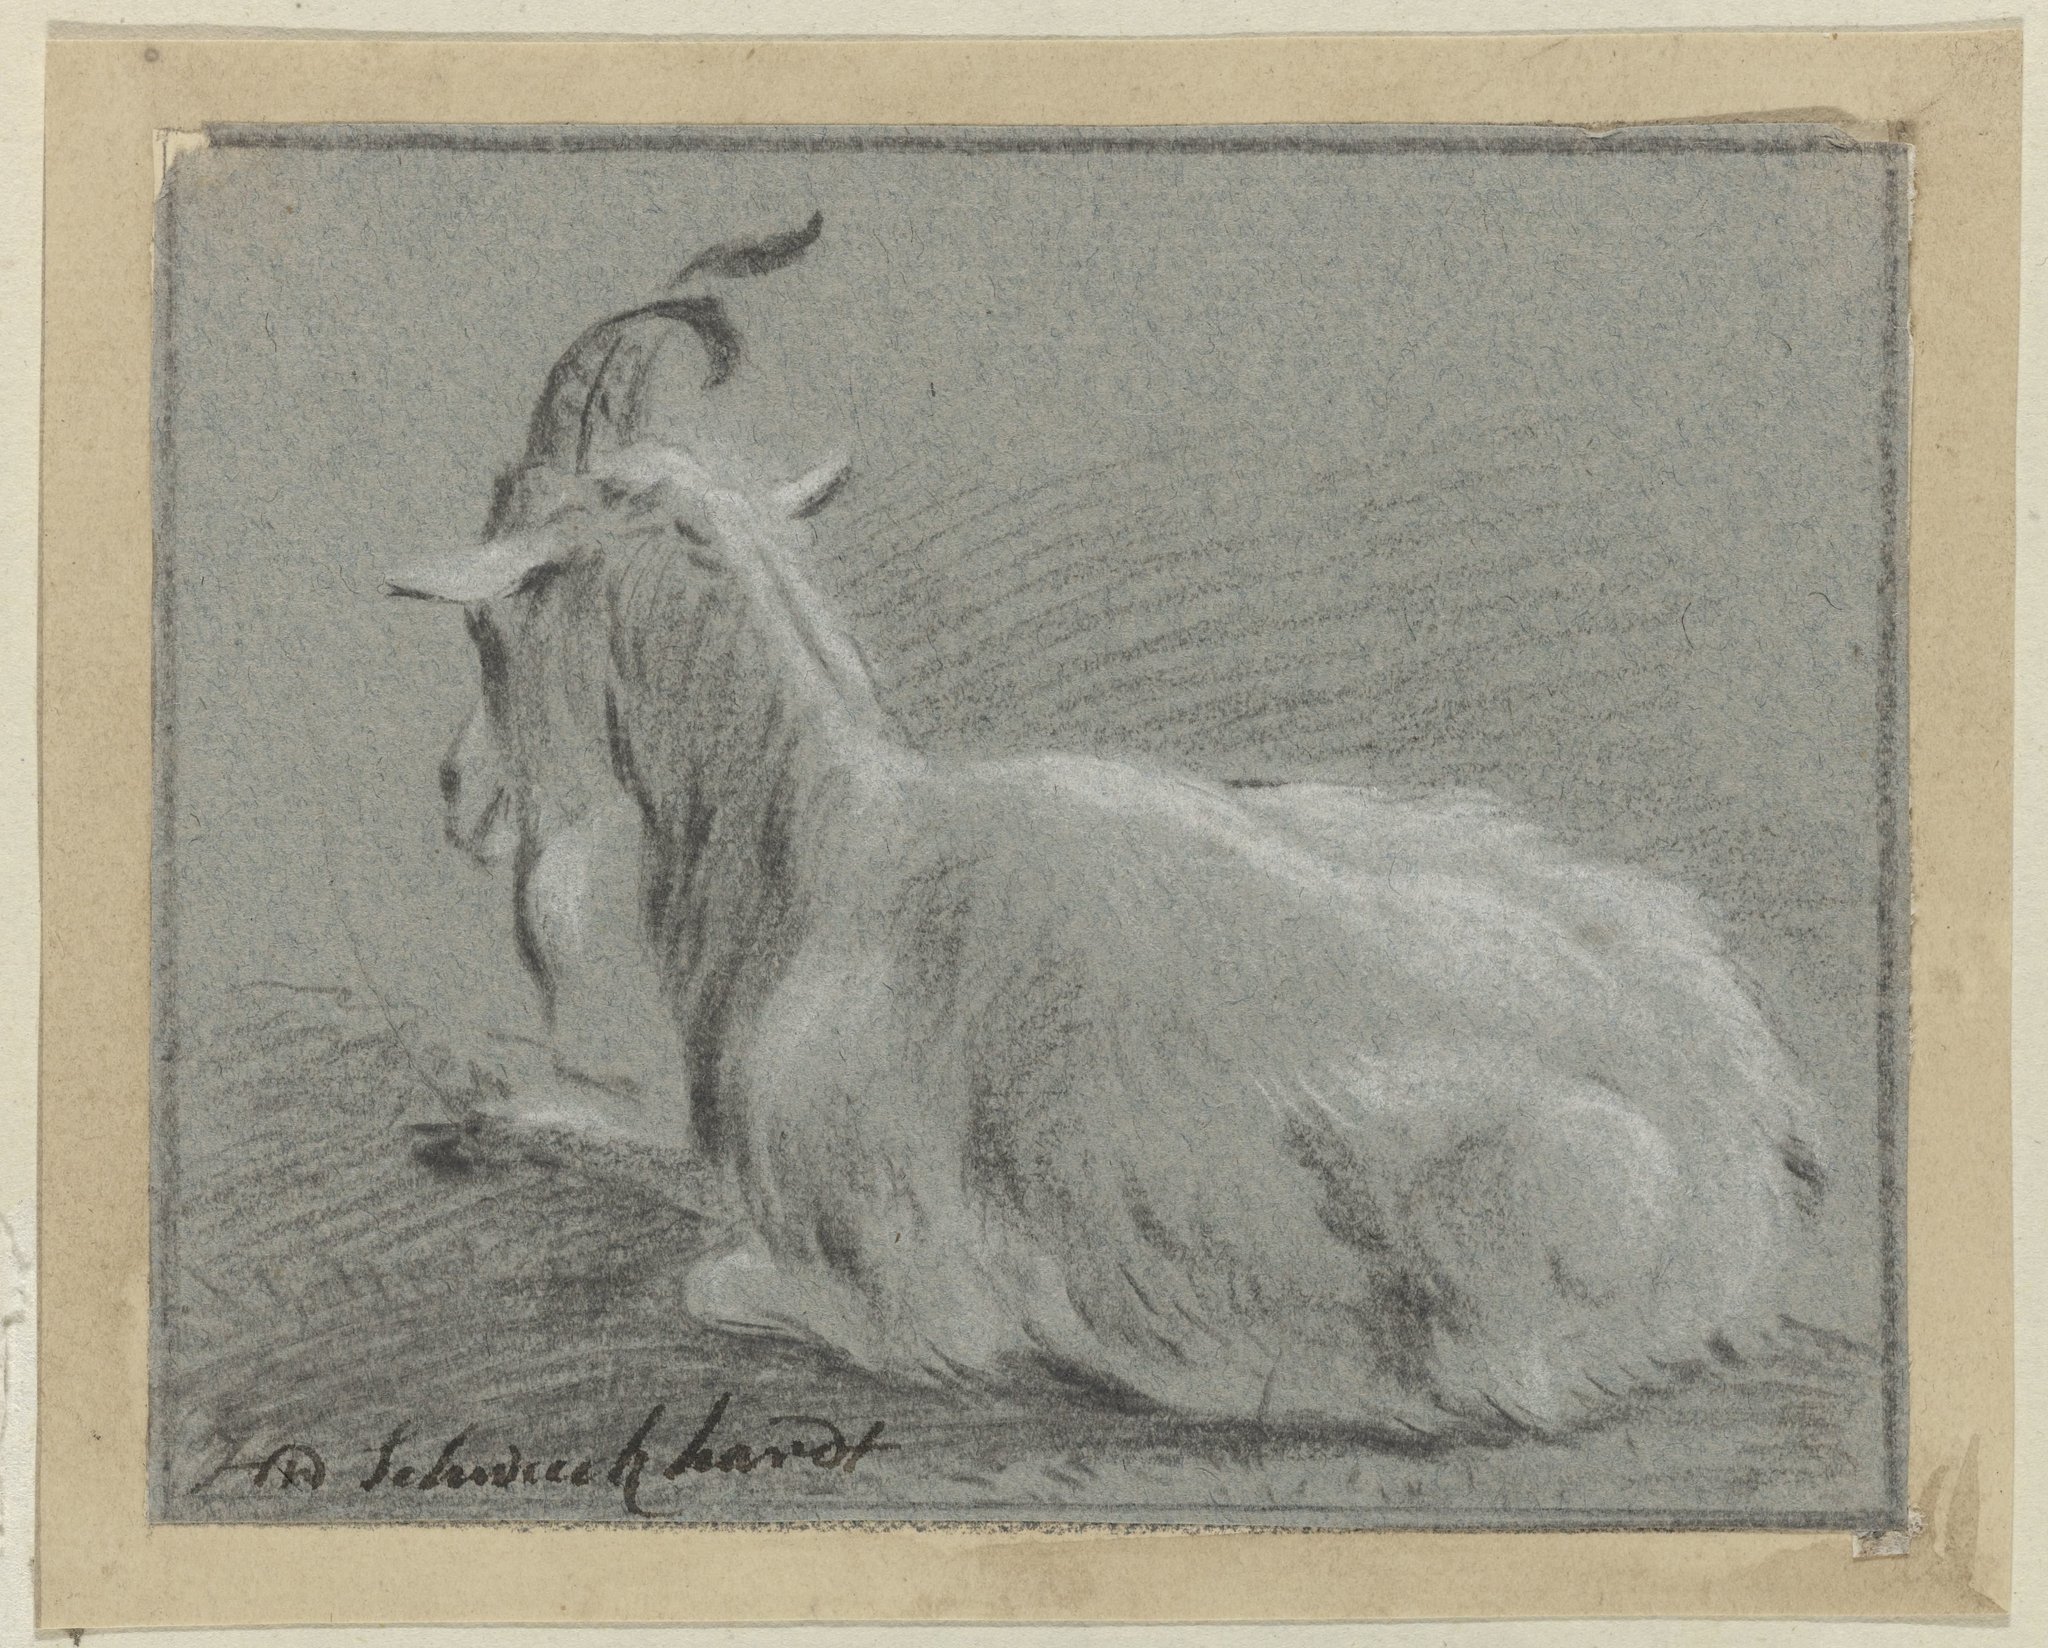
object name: drawing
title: Liggende geit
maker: hendrik willem schweickhardt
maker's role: draughtsman, painter, print maker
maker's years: 1746-1797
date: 1756-1797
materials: chalk, paper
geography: netherlands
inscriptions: signature: ‘HW Schweickhardt’